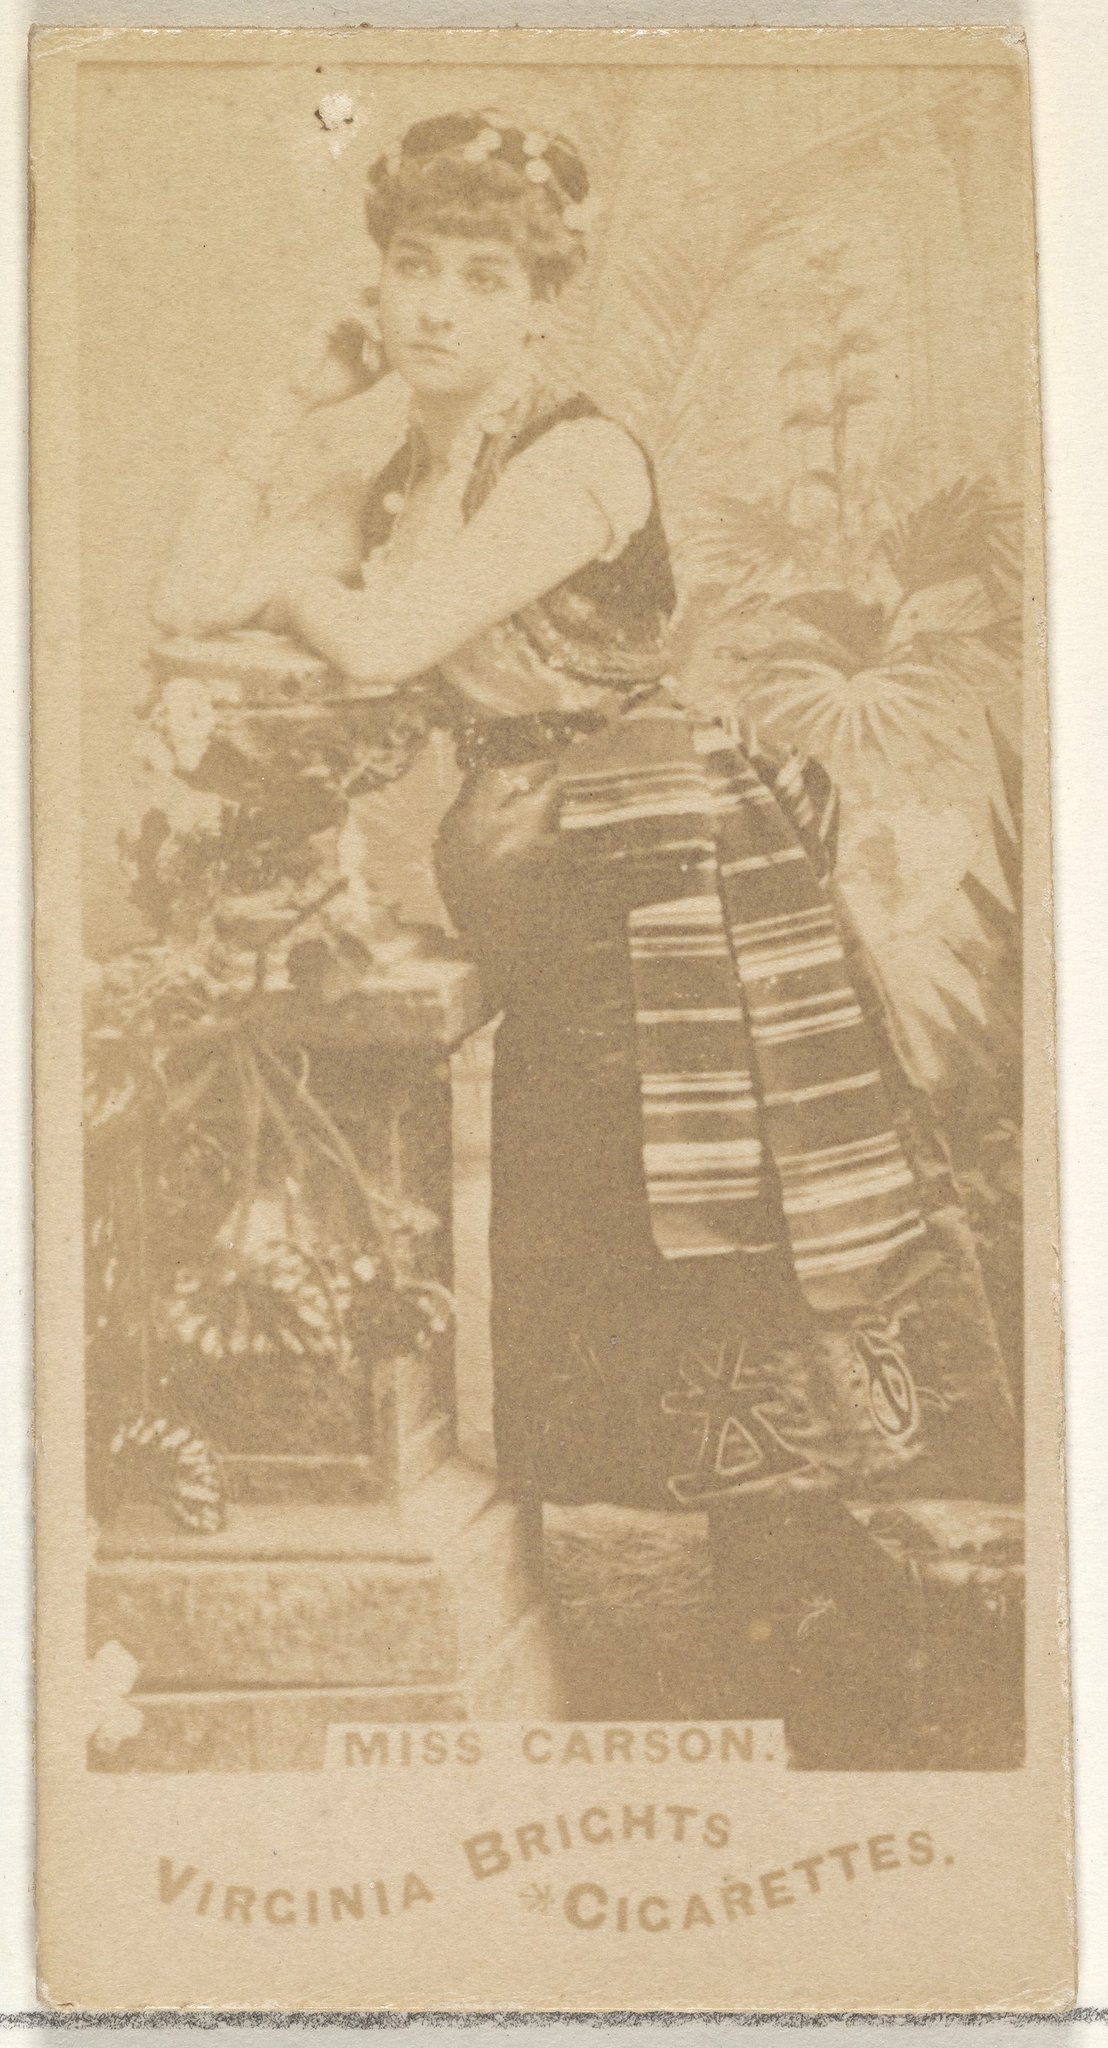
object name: photograph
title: Miss Carson, from the Actors and Actresses series (N45, Type 1) for Virginia Brights Cigarettes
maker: allen & ginter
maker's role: publisher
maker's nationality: american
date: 1888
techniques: albumen silver print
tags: portraits,women,actresses